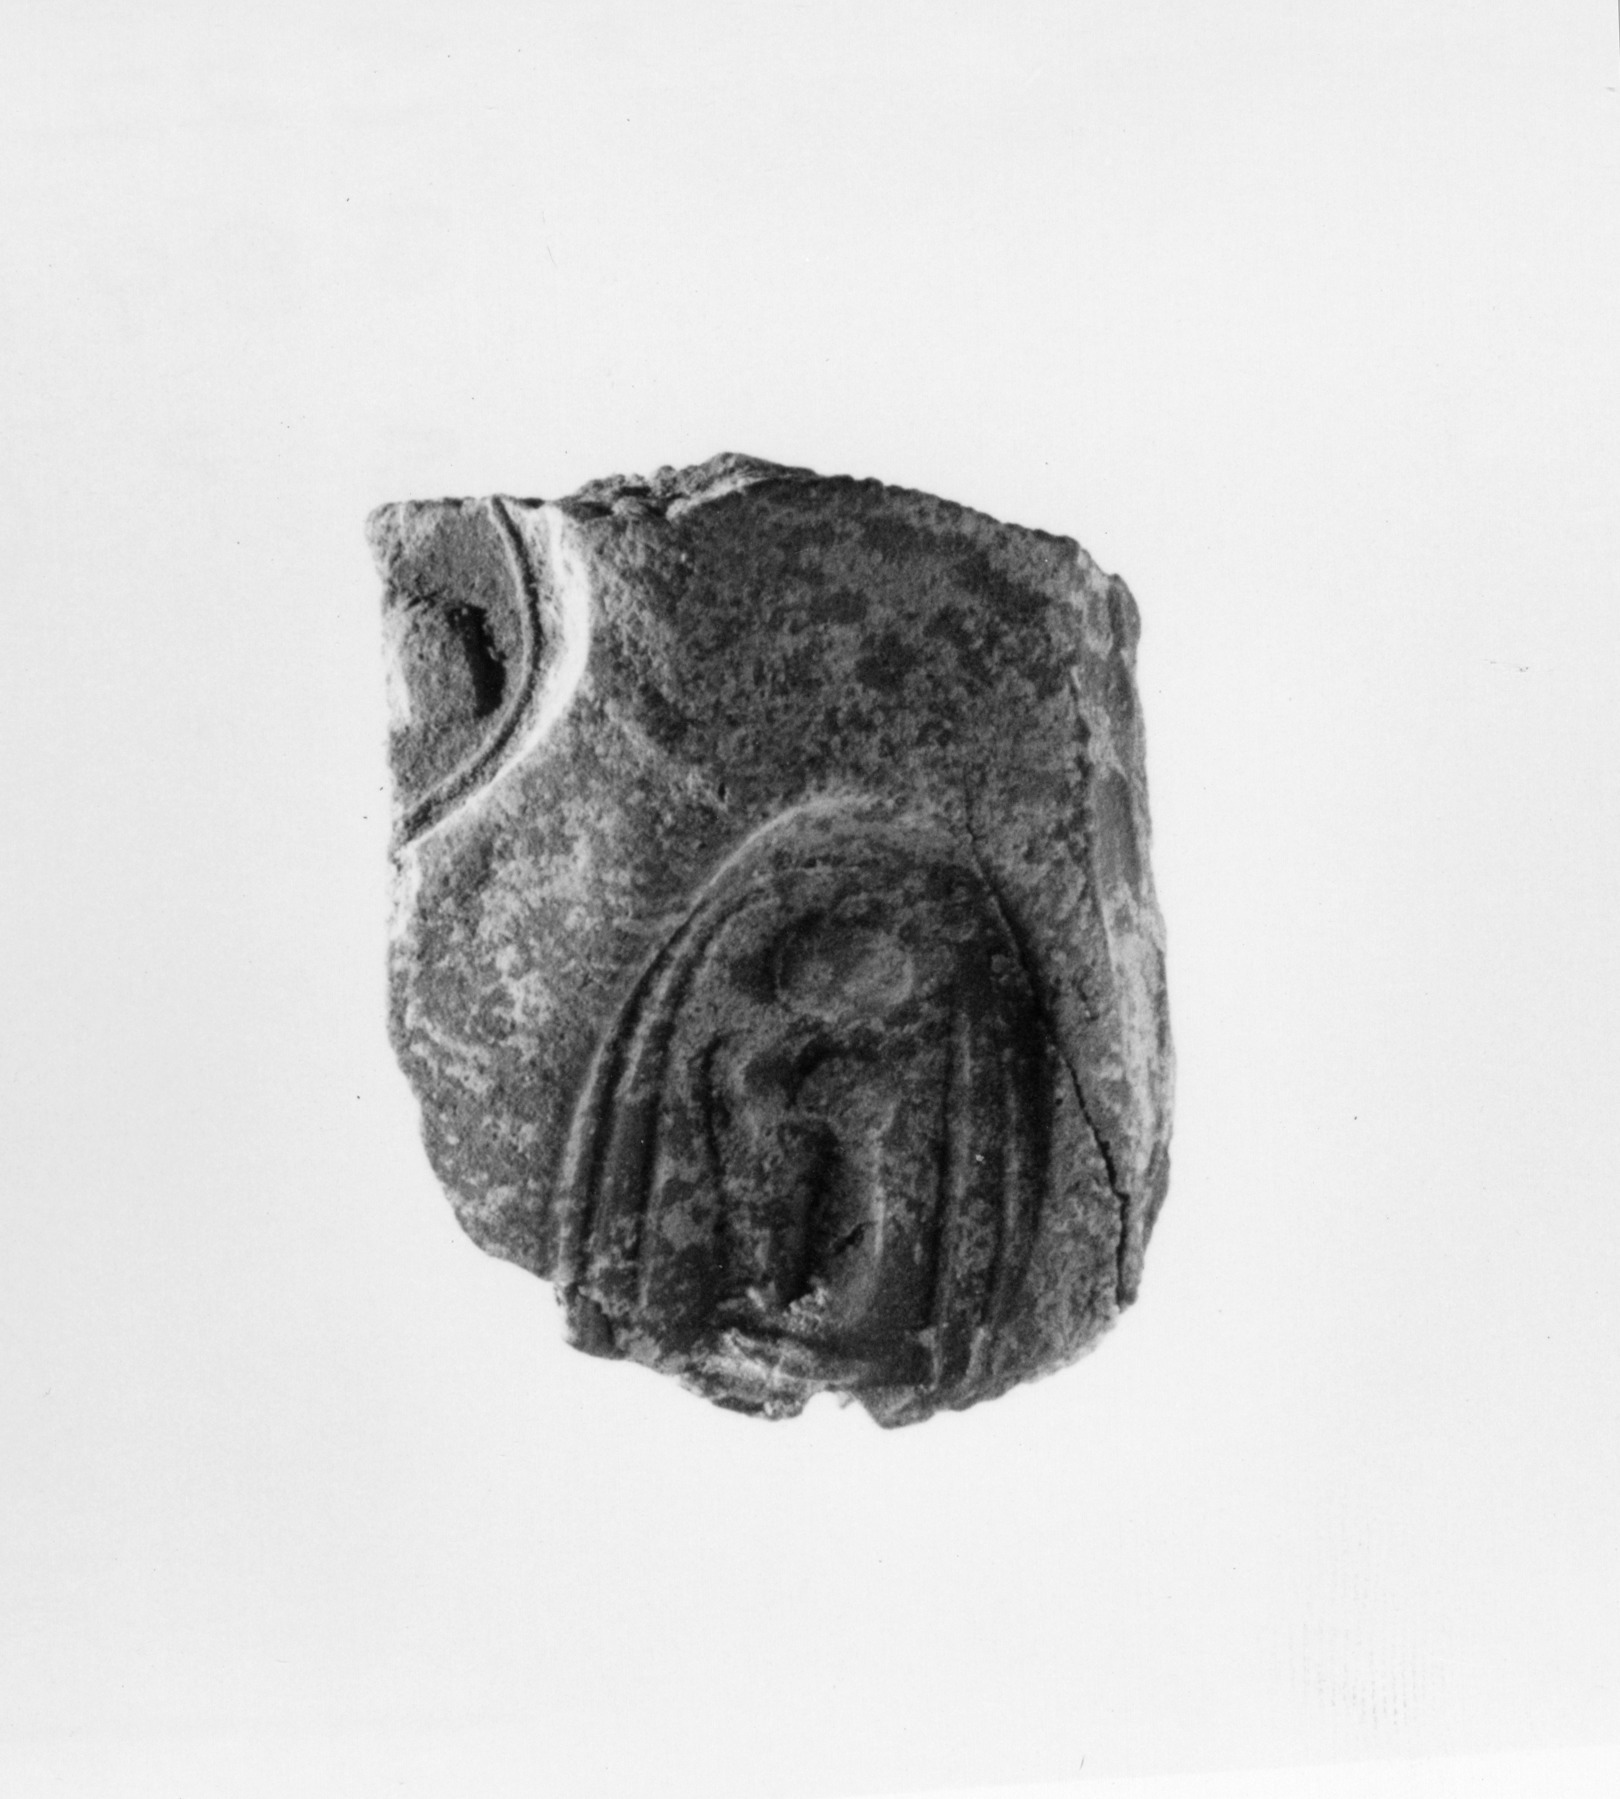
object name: sealing, nebmaatre, amenhotep iii,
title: Document Sealing With Multiple Seal Impressions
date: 1390-1352 BCE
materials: mud